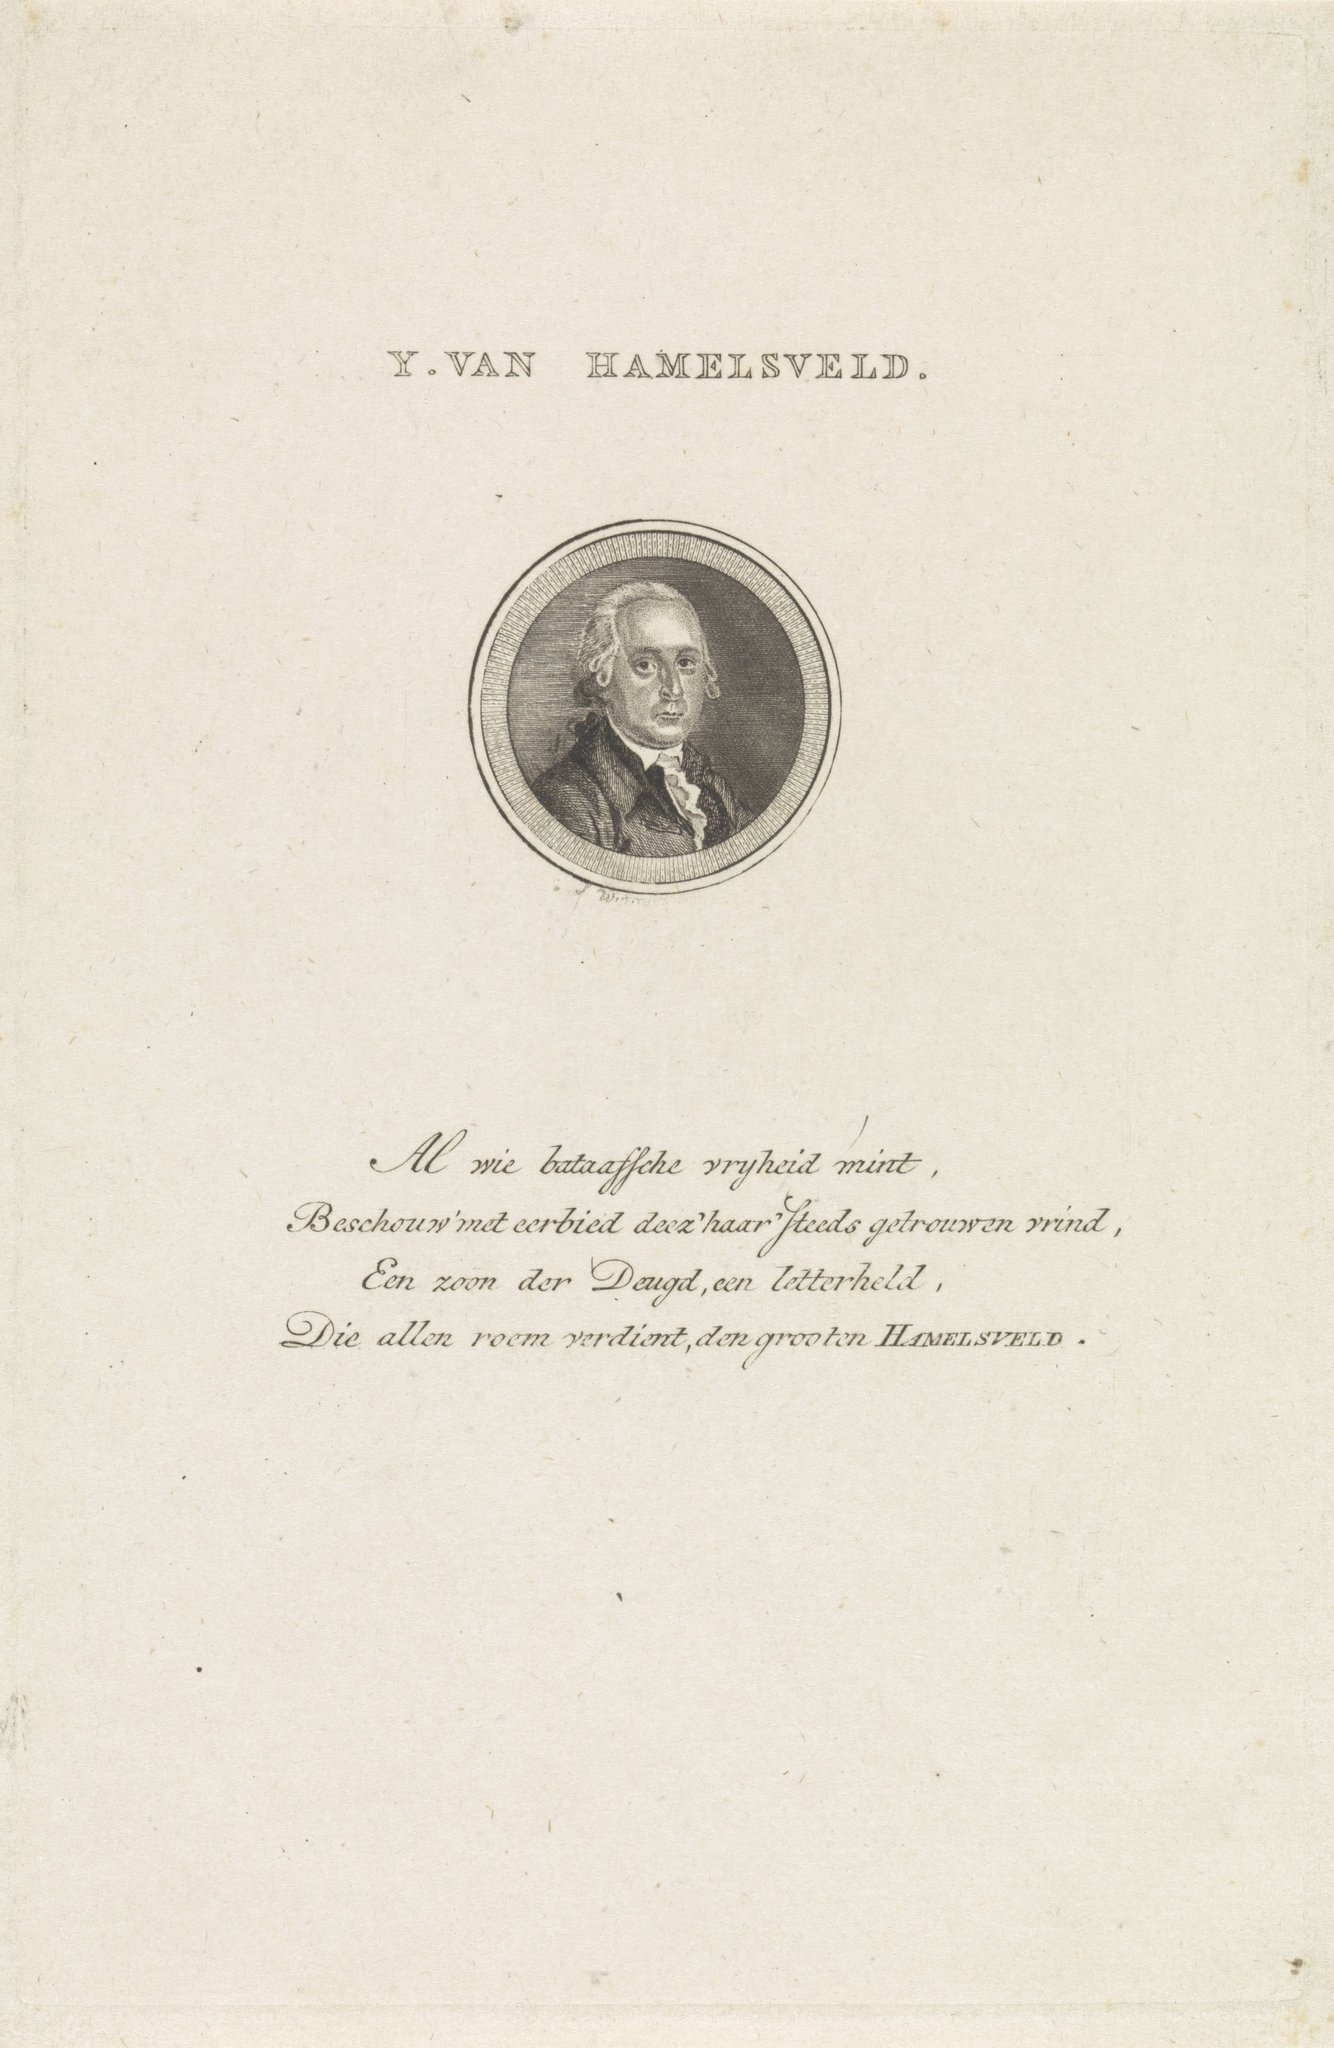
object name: print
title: Portret van IJsbrand van Hamelsveld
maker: jacobus wijsman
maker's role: print maker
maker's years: 1768-1827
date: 1795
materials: paper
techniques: engraving, etching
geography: amsterdam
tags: utrecht, amsterdam, ijsbrand van hamelsveld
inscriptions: collector's mark: Lugt 2228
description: Prent maakt deel uit van een serie, die in drie afleveringen werd uitgegeven onder de titel: Verzameling van Afbeeldingen van Nederlandsche Mannen, beroemd geworden, wegens hunne Moed en Burgerliefde in de jongstledene Beroerten. 1794-1795. Zie Atlas van Stolk.